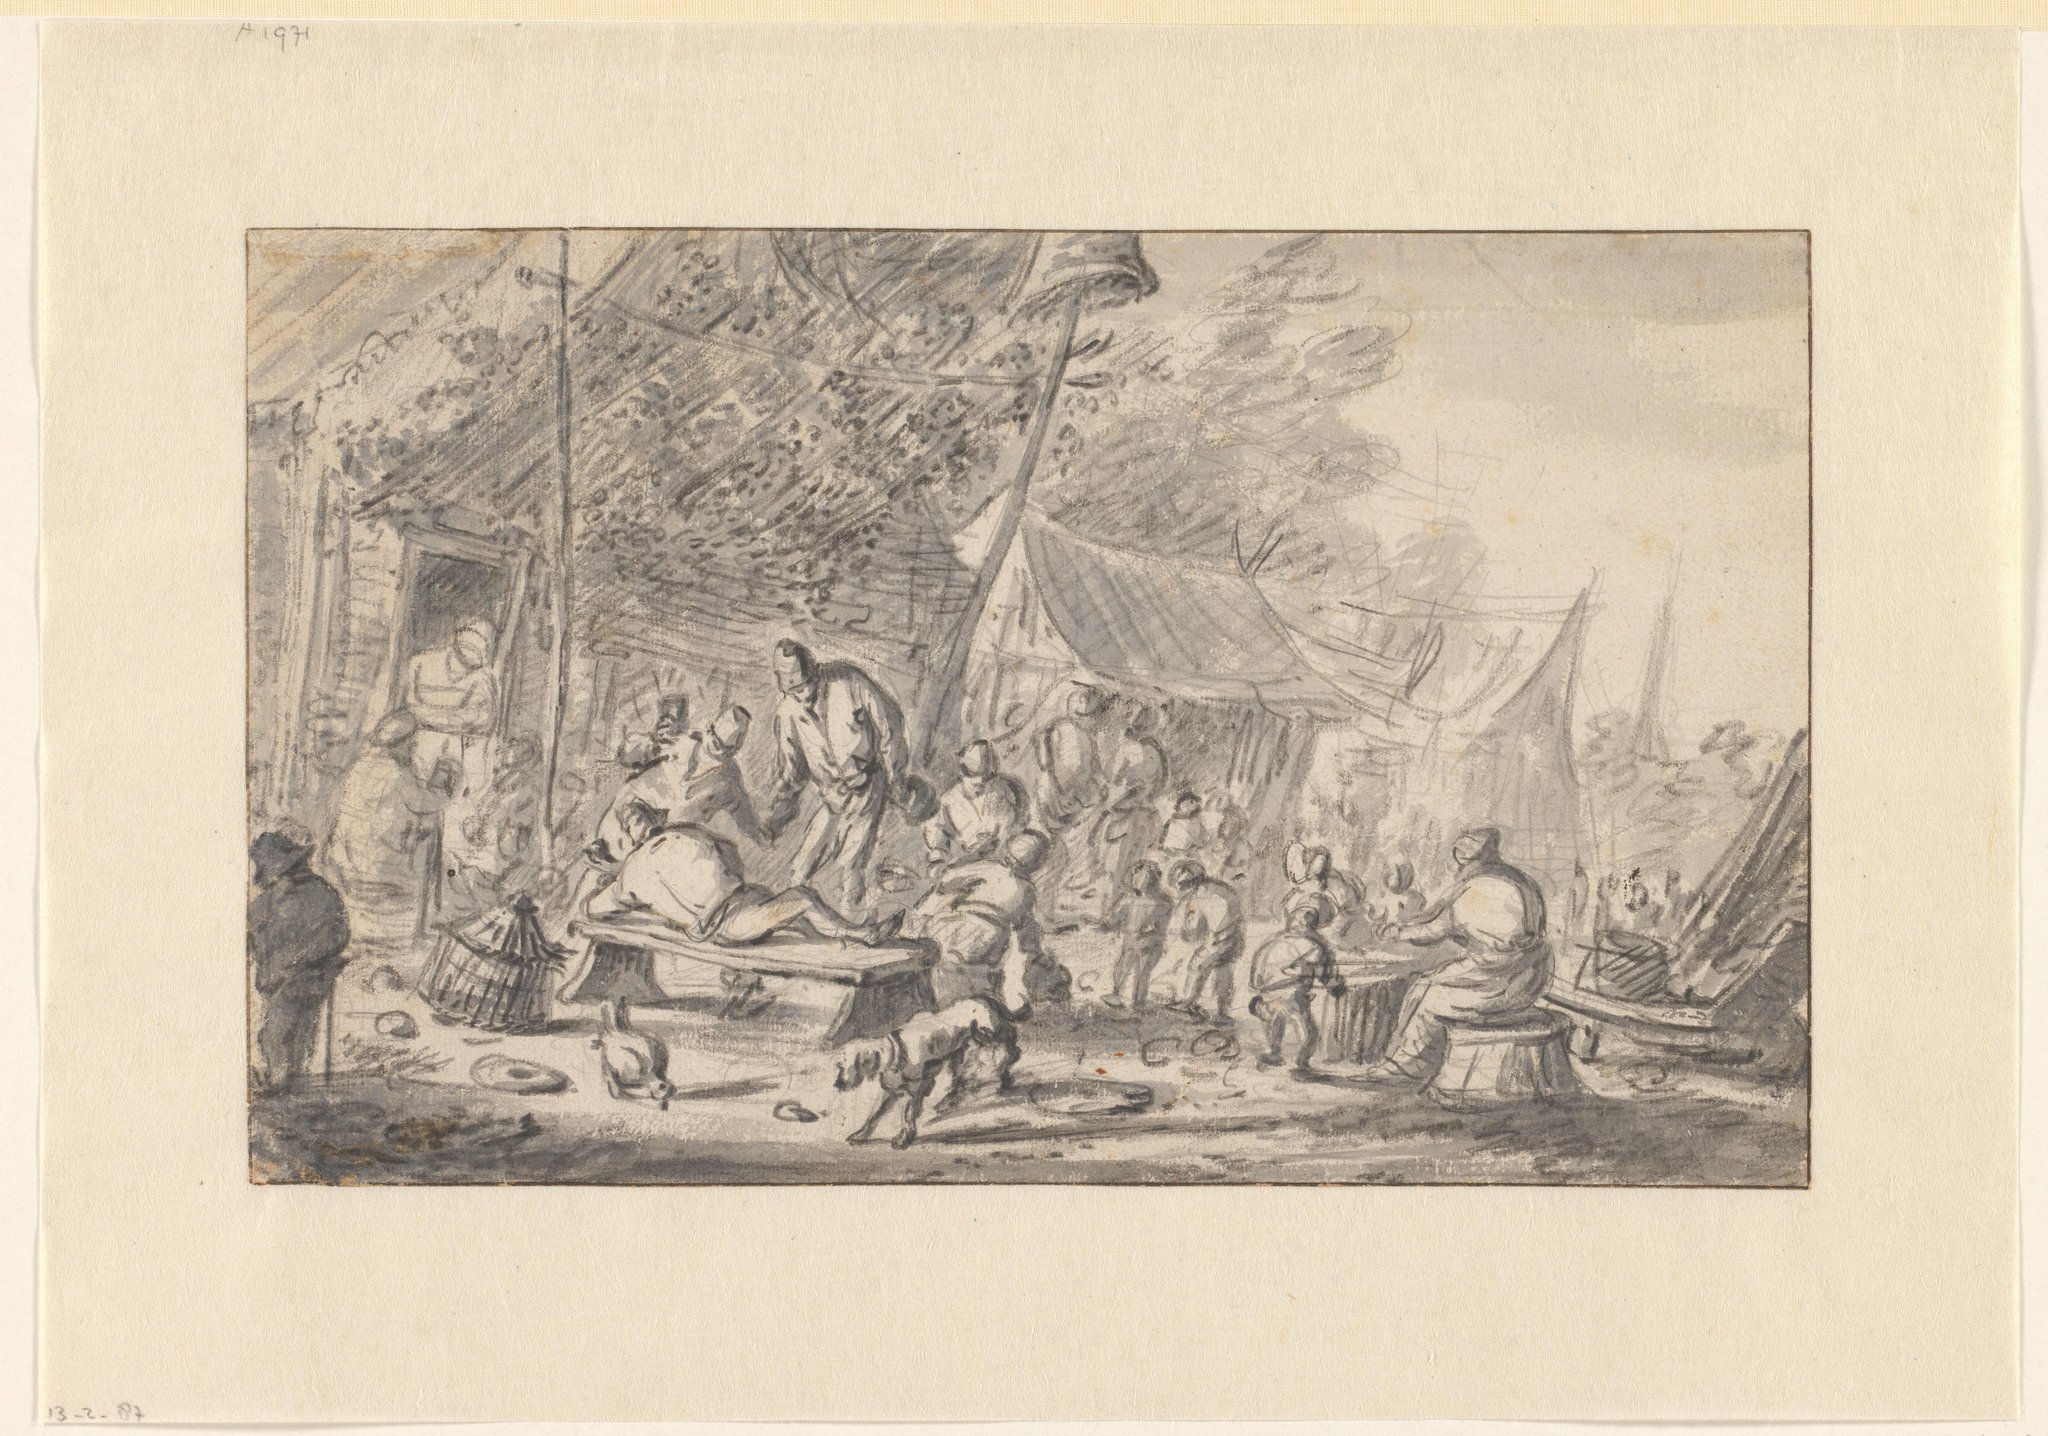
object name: drawing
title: Dorpskermis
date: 1630-1700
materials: chalk, paper, pencil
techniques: brush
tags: (annual) fair, trade fair